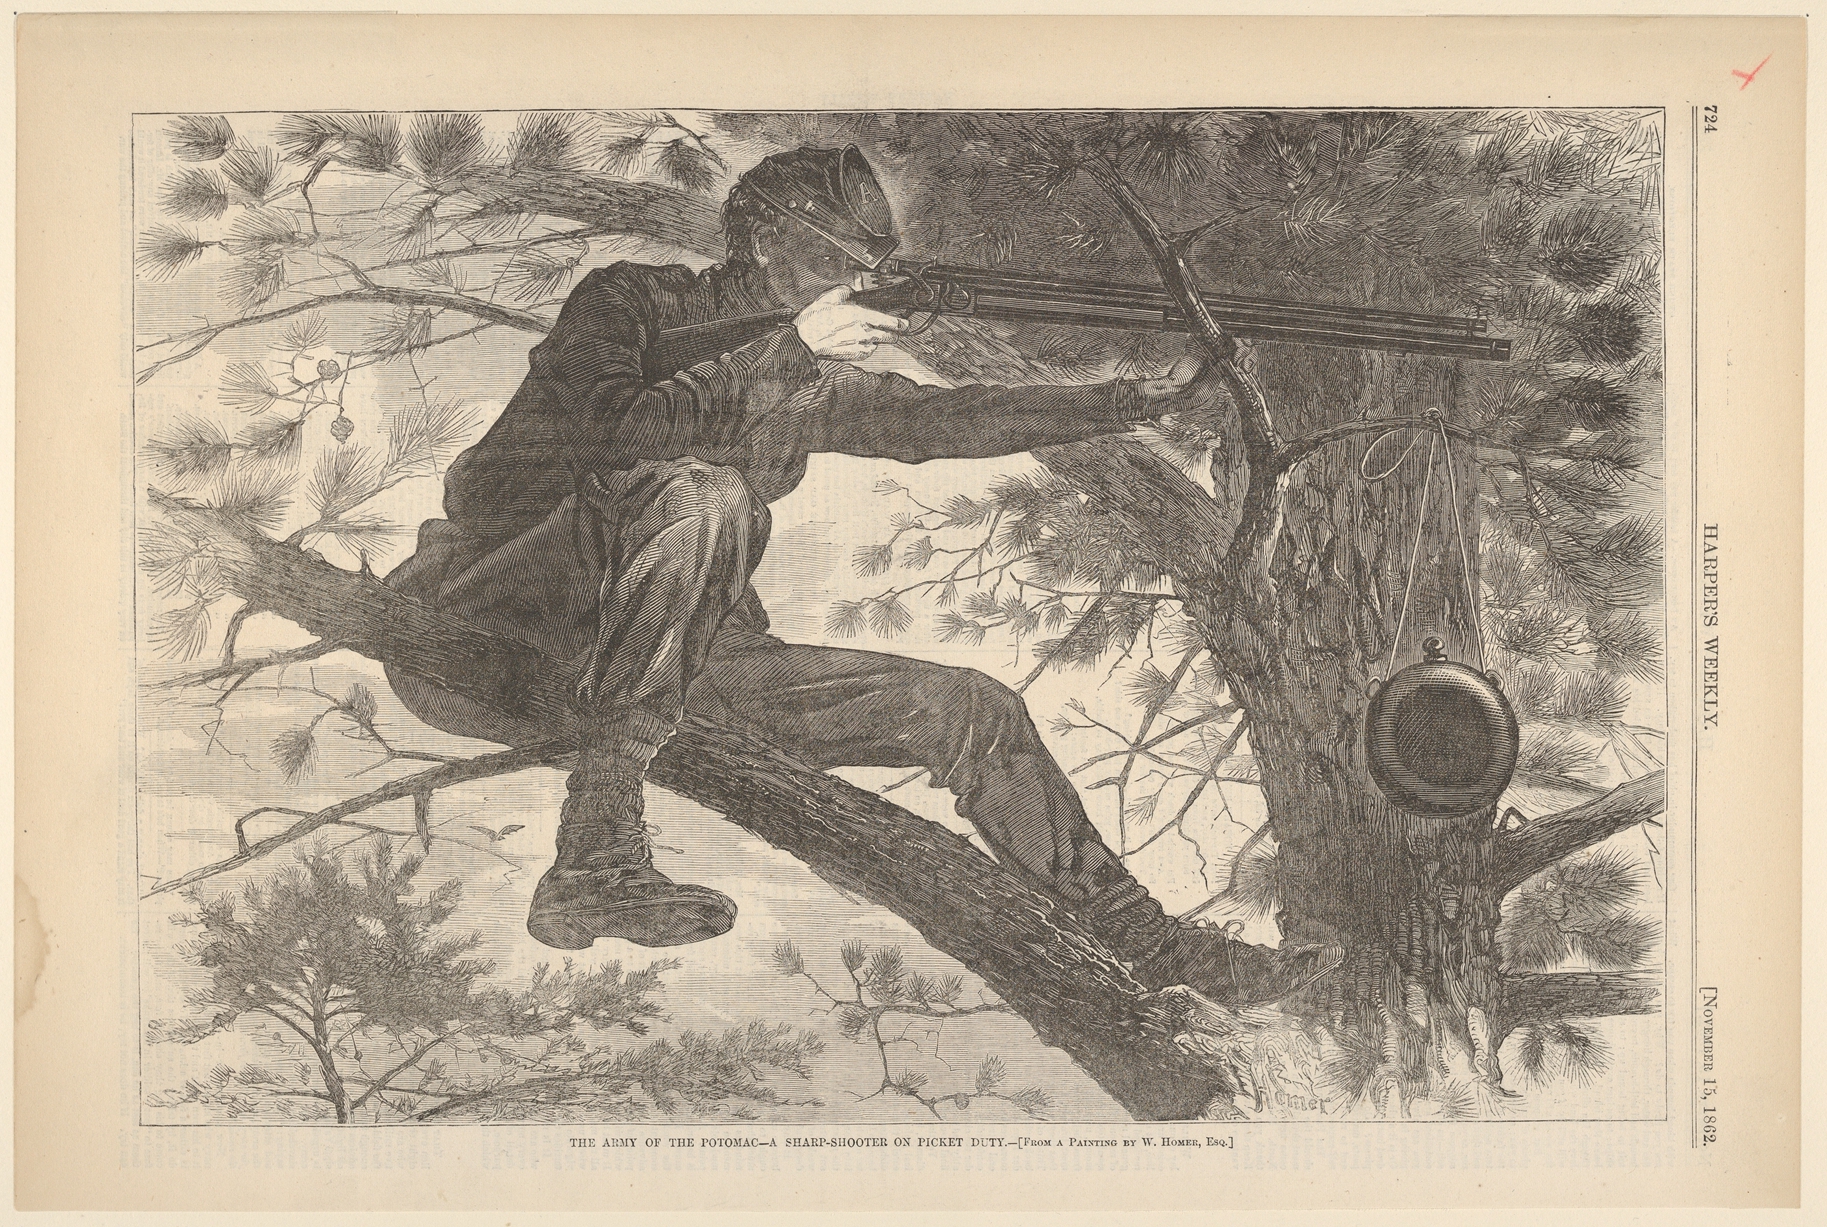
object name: print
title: The Army of the Potomac – A Sharp-Shooter on Picket Duty (from "Harper's Weekly," Vol. VII)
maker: winslow homer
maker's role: artist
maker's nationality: american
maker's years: 1836-1910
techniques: engraving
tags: soldiers,firearms,american civil war,men